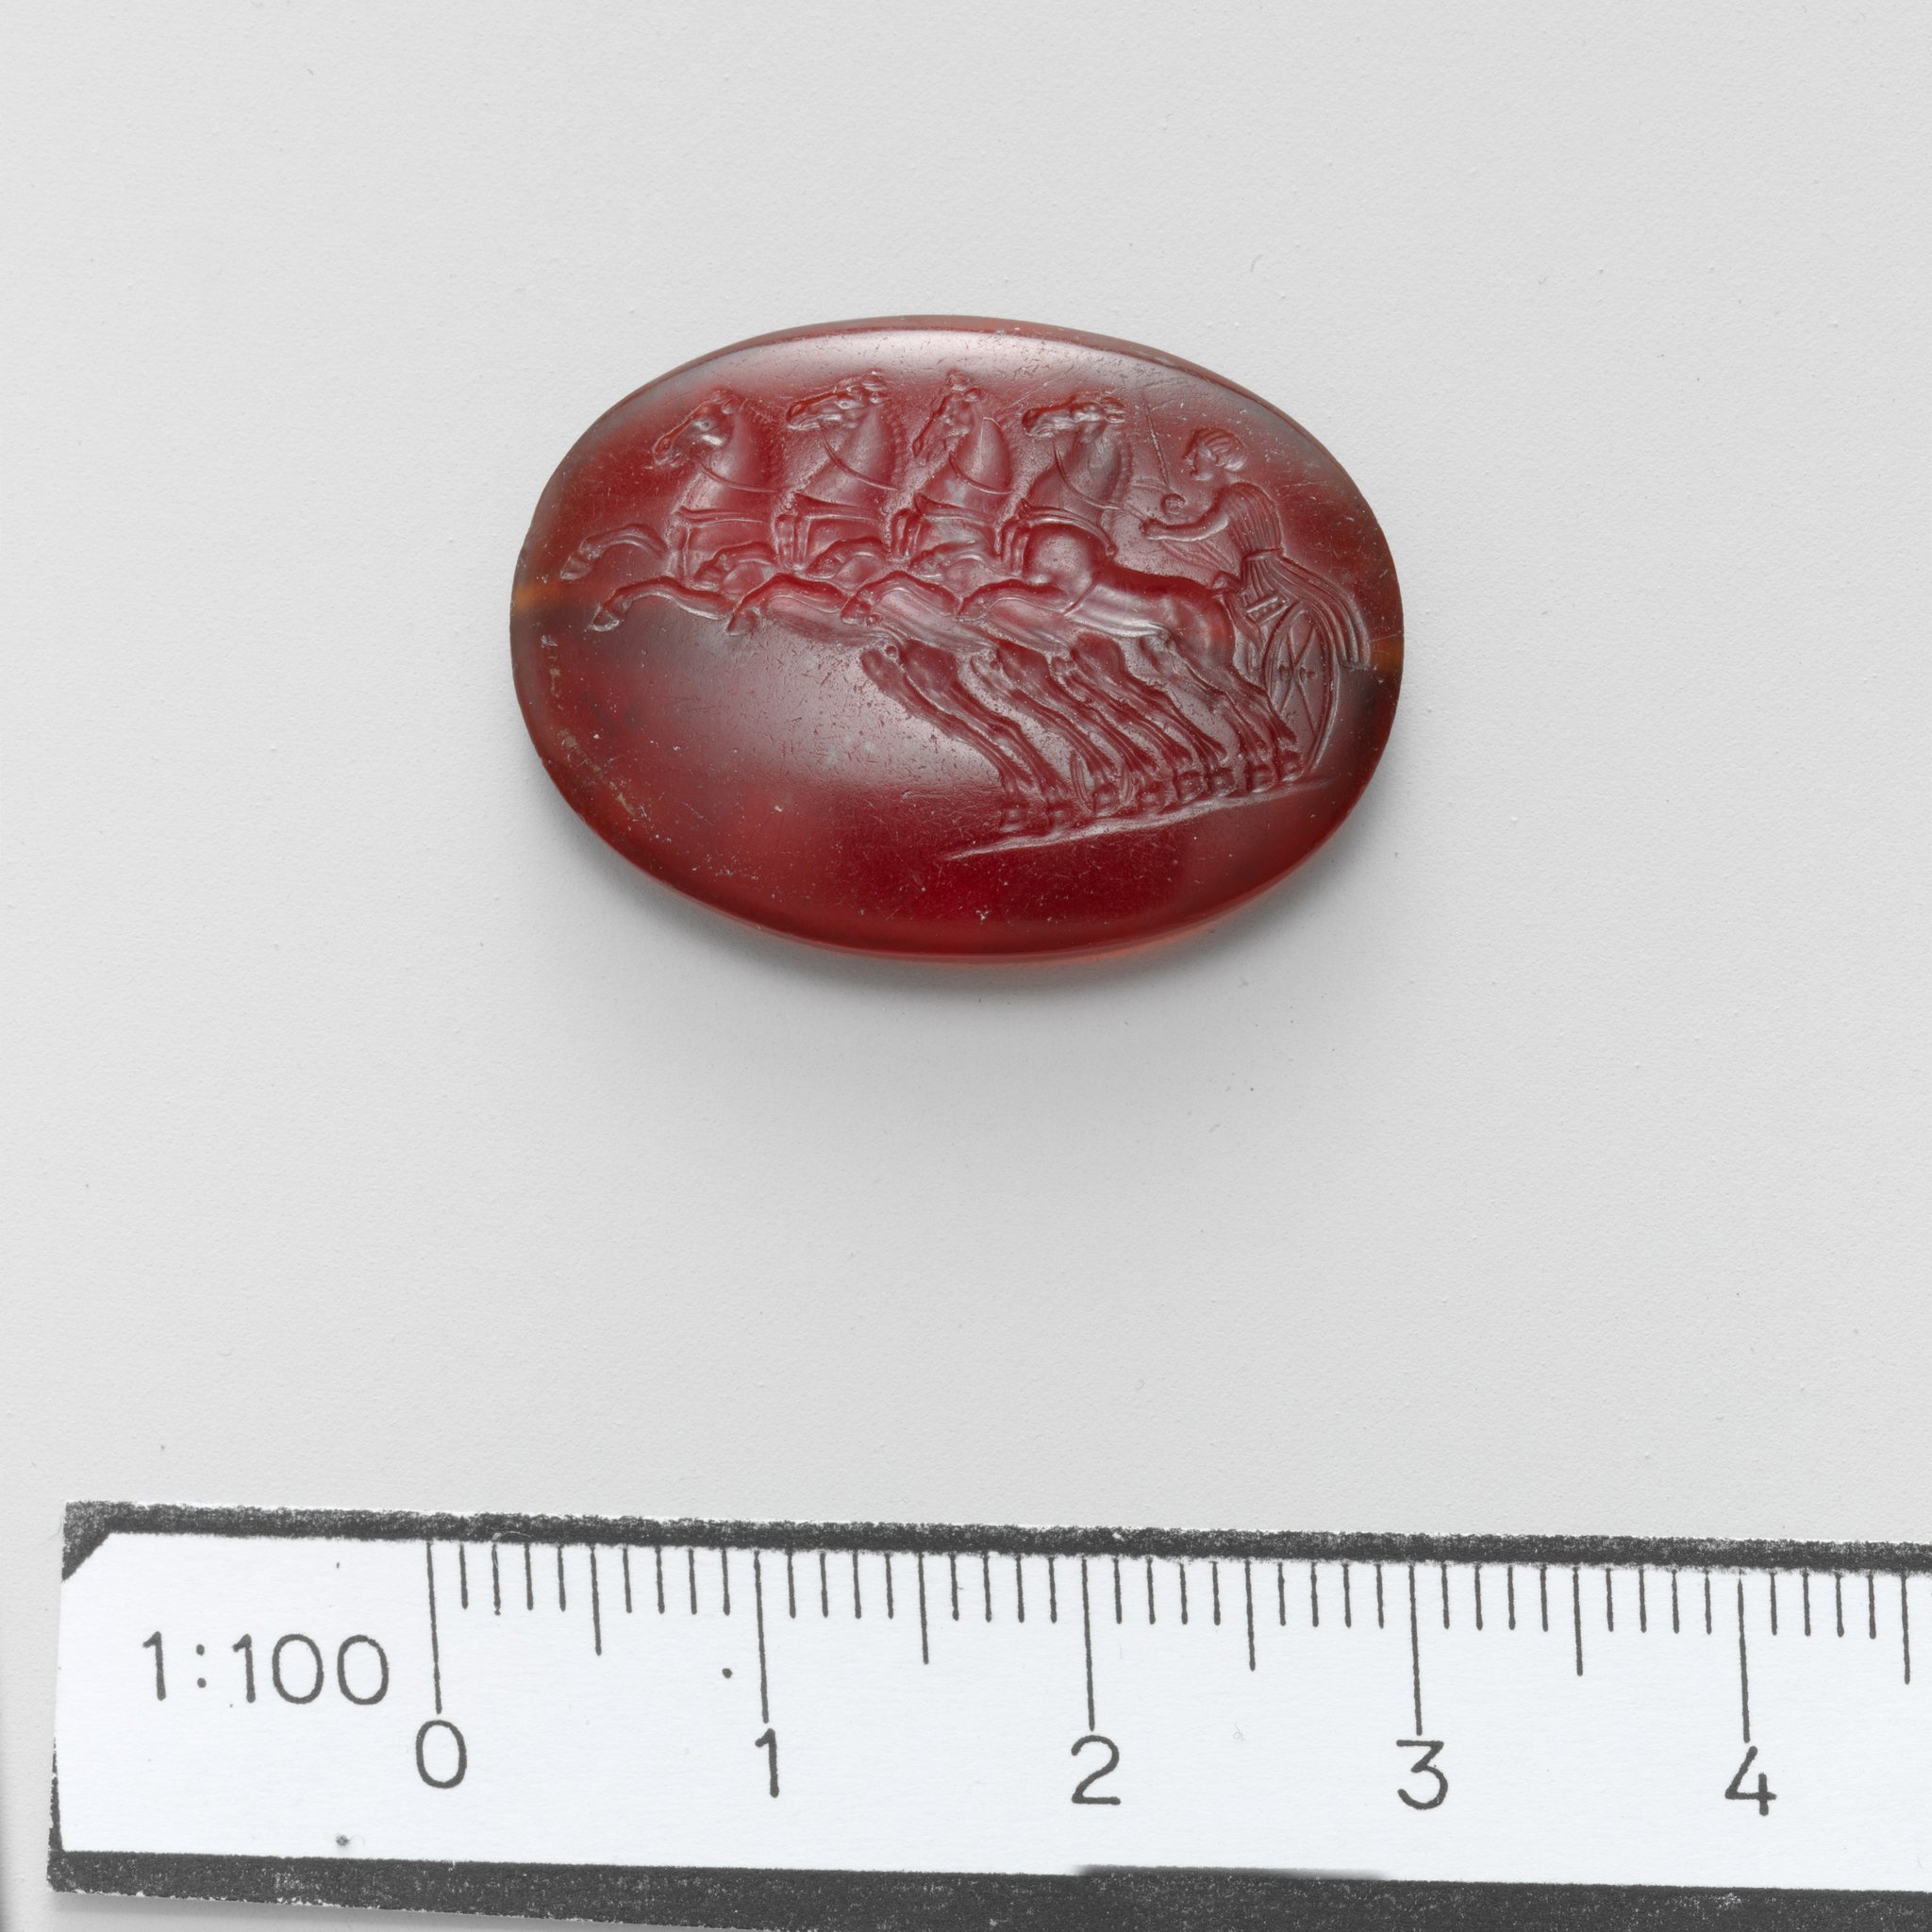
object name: scaraboid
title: Carnelian flat scaraboid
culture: greek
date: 350-301 BCE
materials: gemstone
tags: human figures,horses,chariots